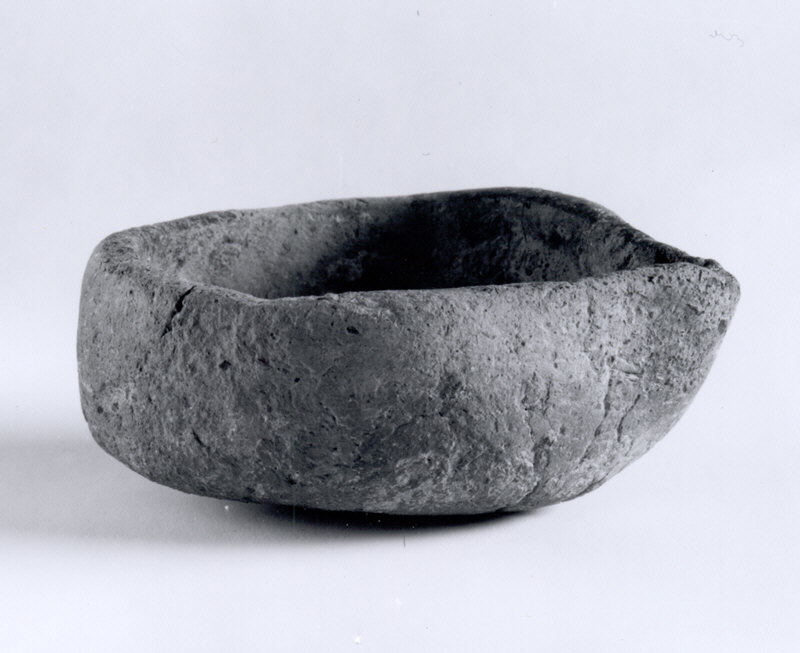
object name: lamp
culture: seleucid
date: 400-201 BCE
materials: ceramic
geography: iran